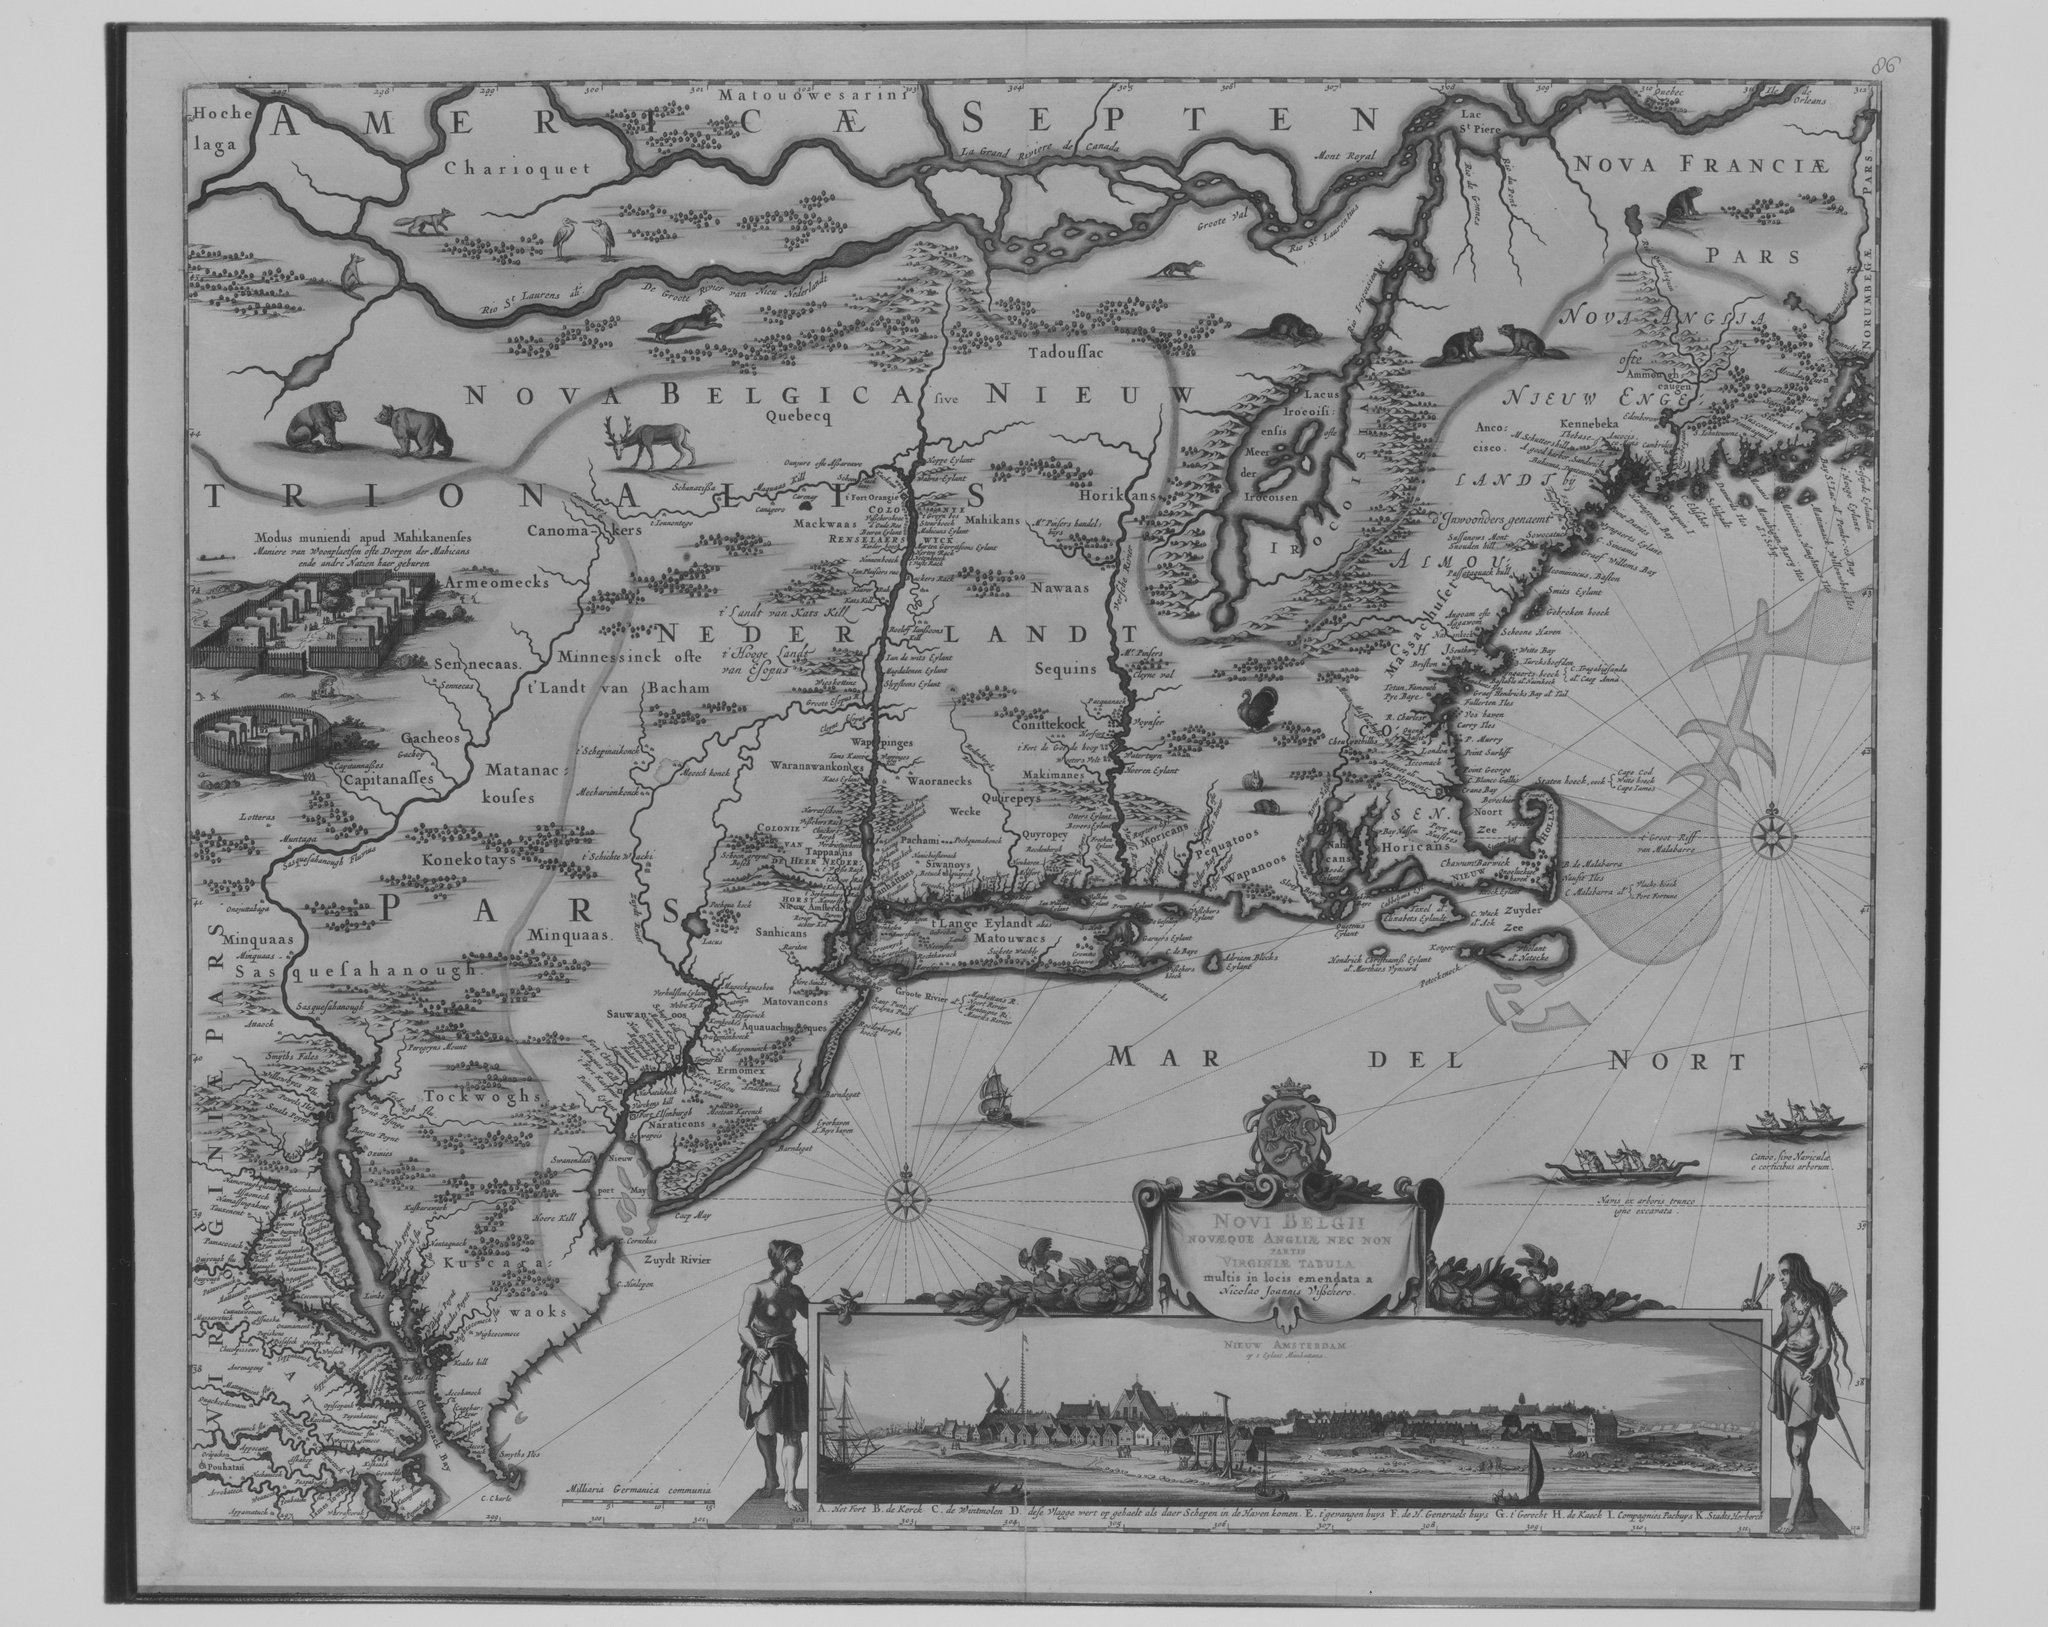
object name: print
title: Novi Belgii, Novaeque Angliae nec non partis Virginiae tabula [Map of New Netherlands, New England, and part of Virginia]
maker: nicolas visscher i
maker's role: publisher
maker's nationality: dutch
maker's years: 1618-1679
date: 1656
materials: gold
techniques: engraving, etching, hand coloring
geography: netherlands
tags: animals,women,maps